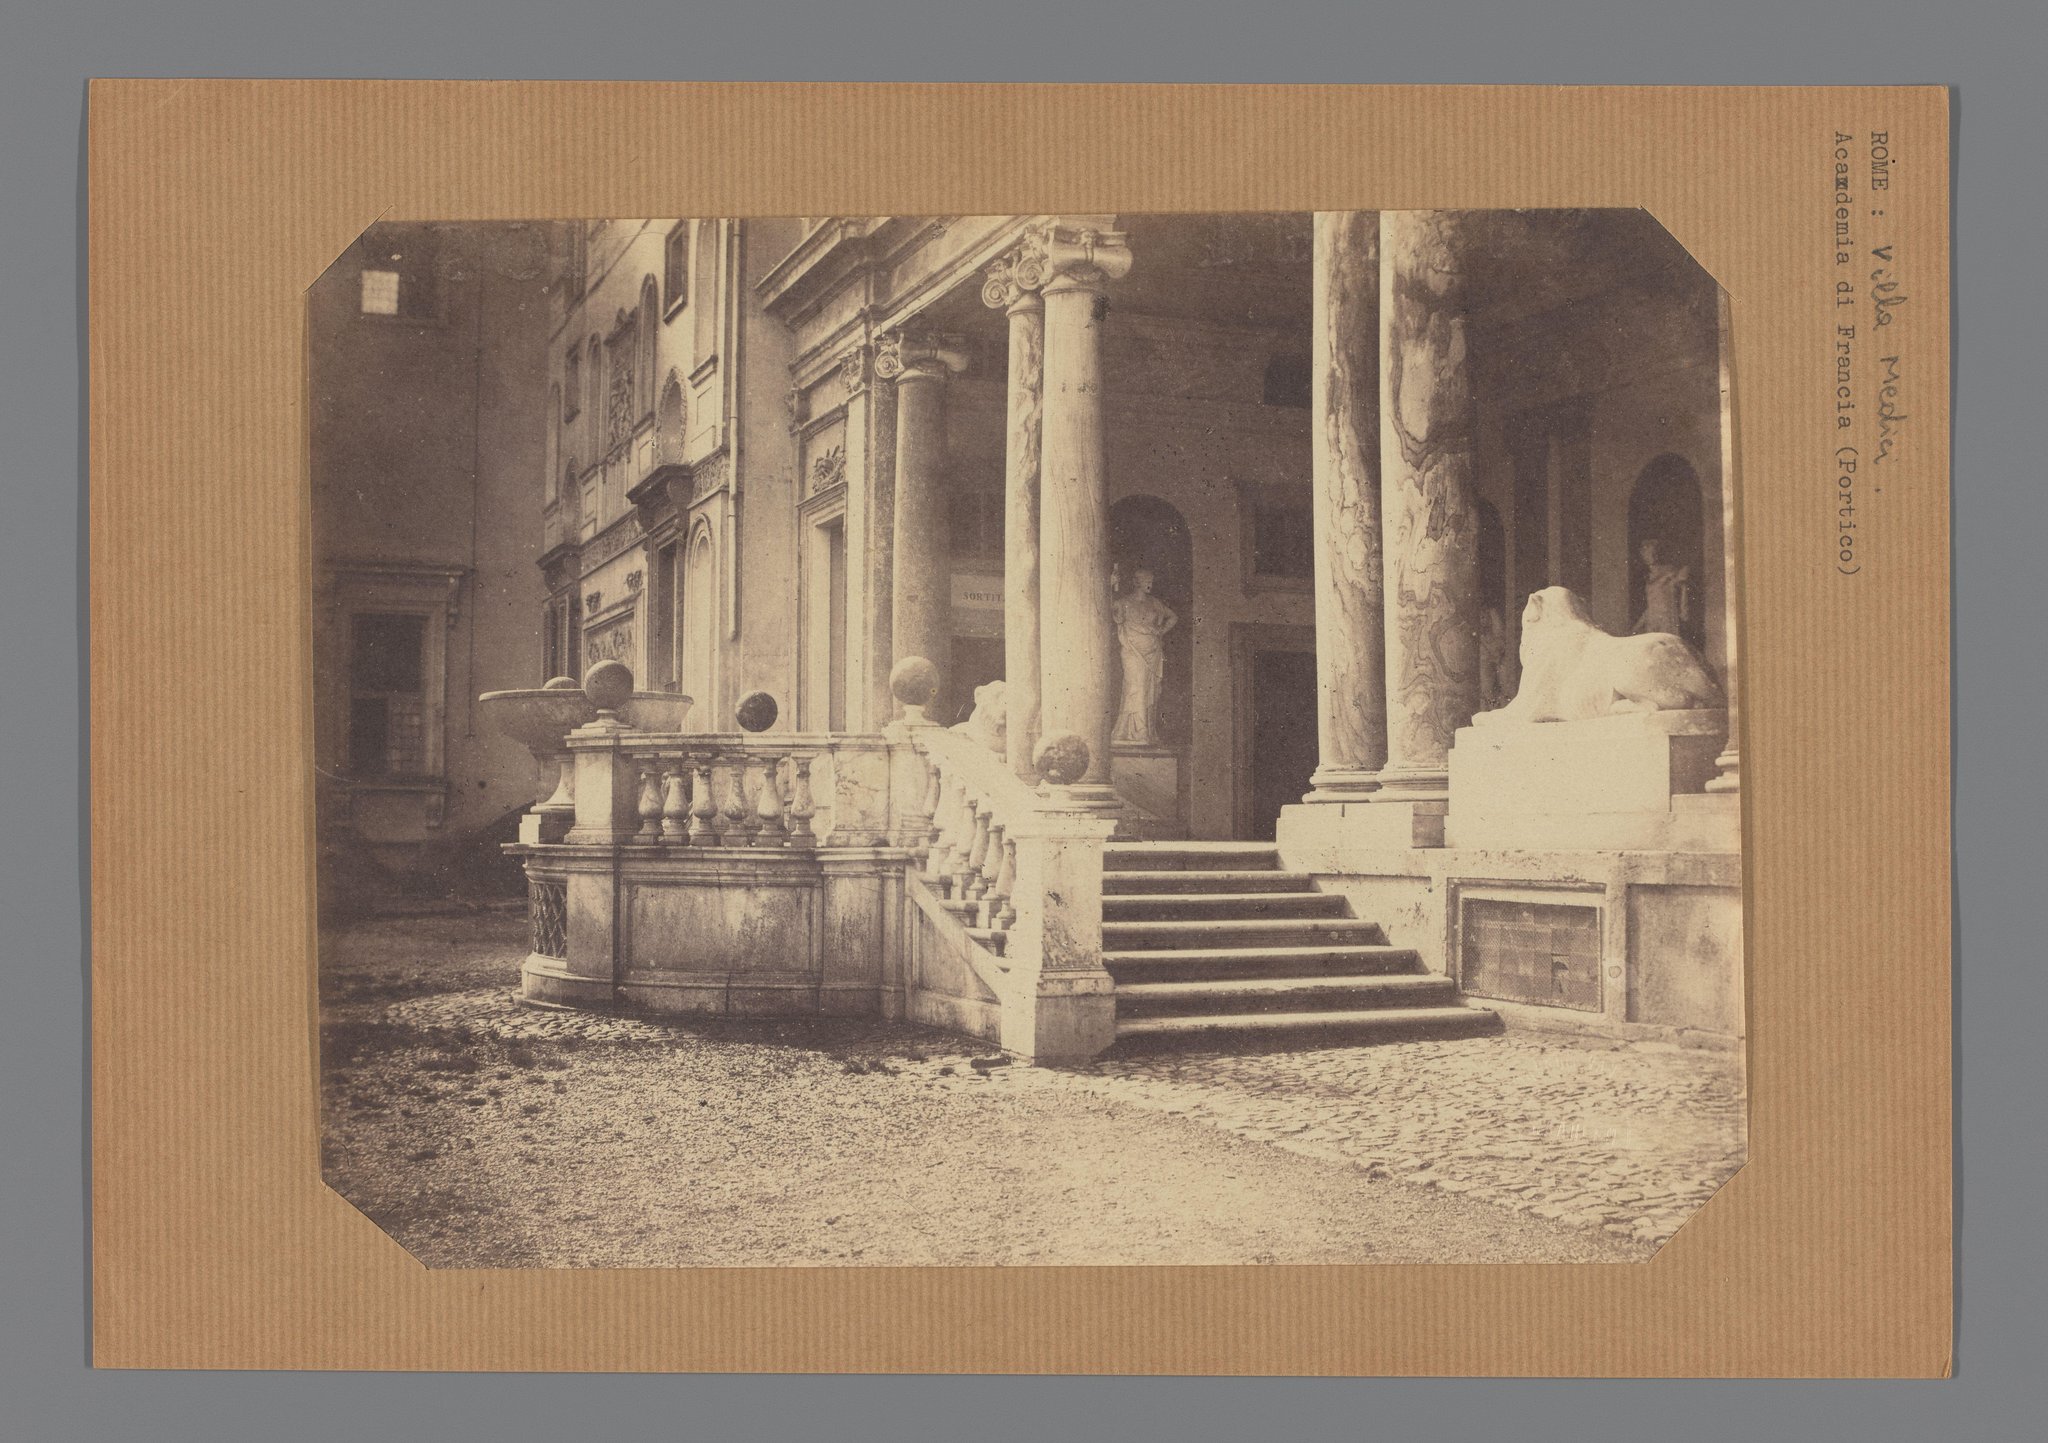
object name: photograph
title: Academia di Francia (Portico)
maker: Anonymous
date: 1850-1860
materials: paper, photographic support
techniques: albumen print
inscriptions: inscription